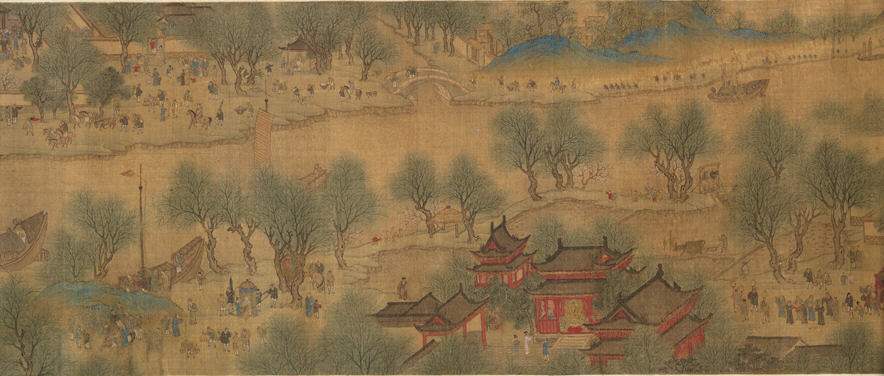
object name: handscroll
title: Spring Festival on the River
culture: chinese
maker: unidentified artist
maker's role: artist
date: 1701-1800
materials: ink, silk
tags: rivers,landscapes,boats